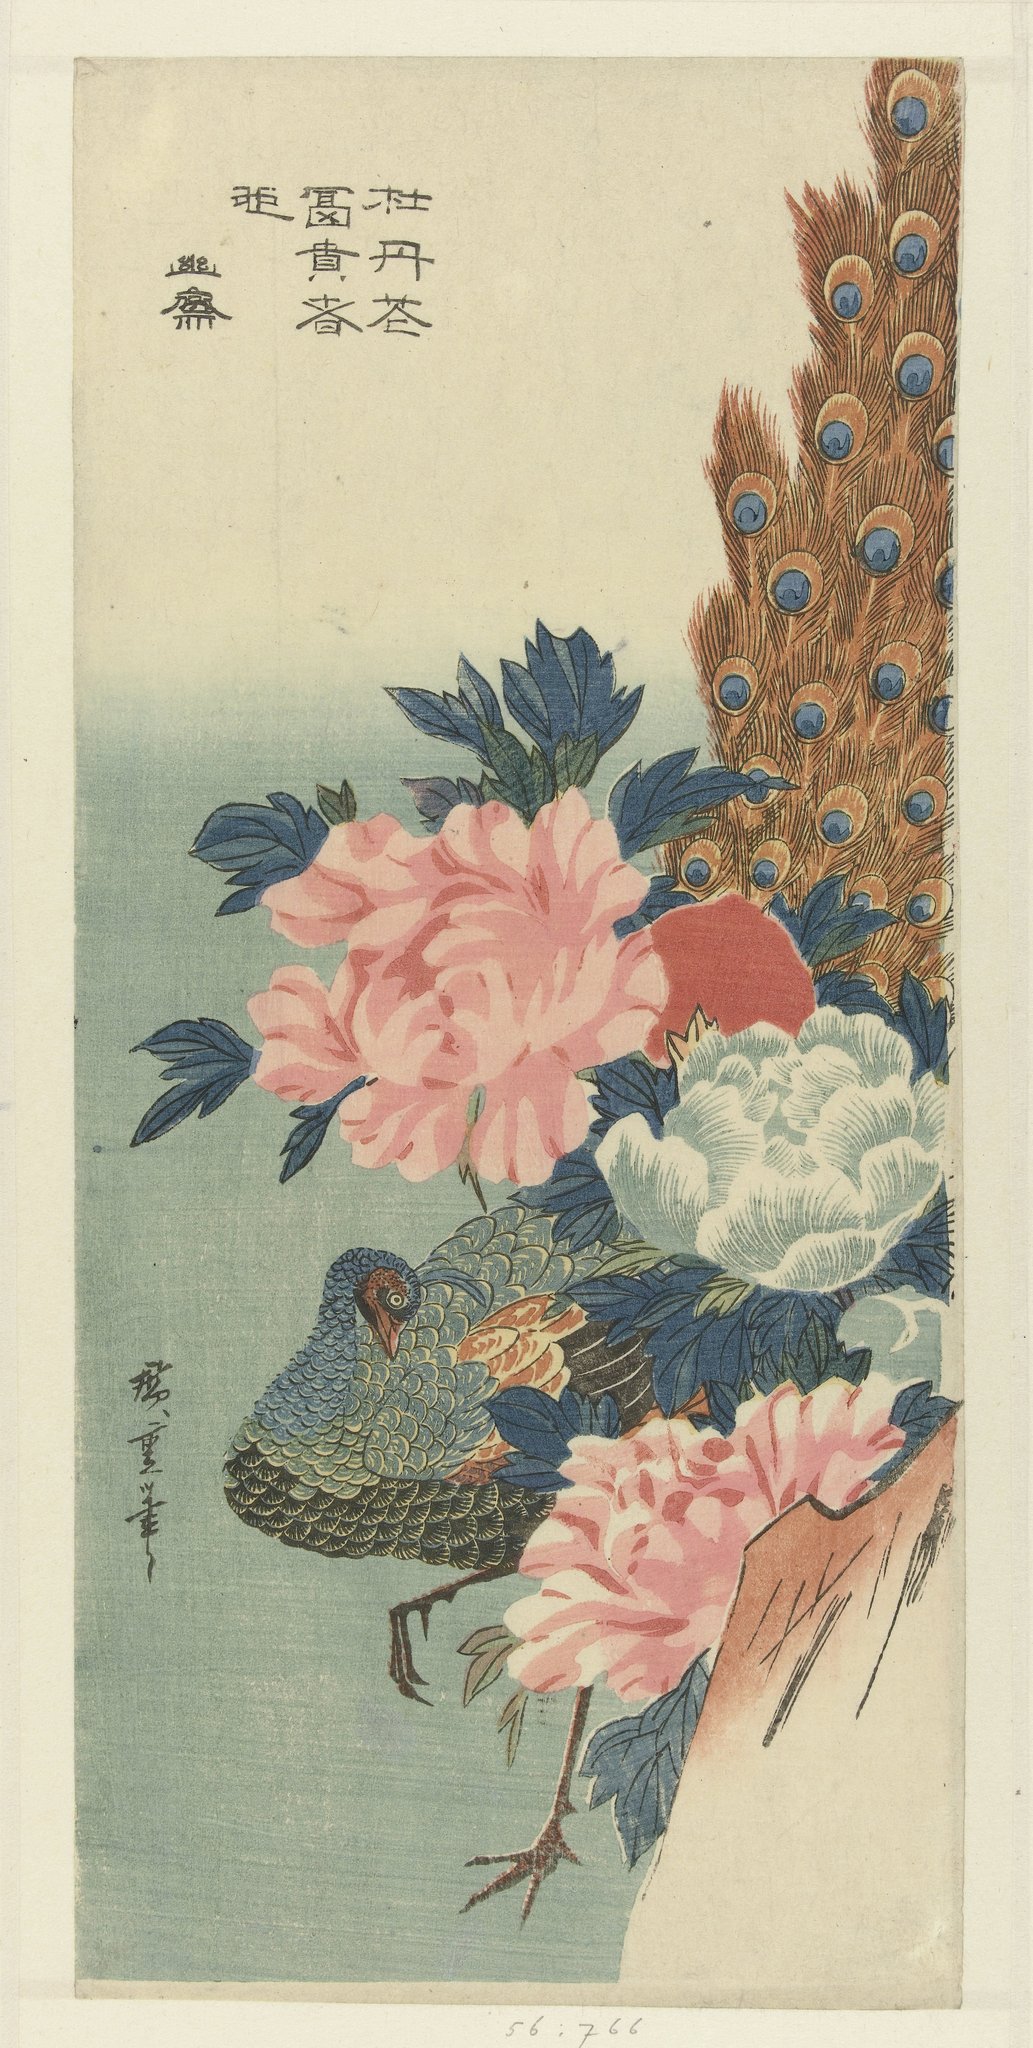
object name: print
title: Pauw en pioenrozen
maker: utagawa hiroshige (i)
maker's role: draughtsman, print maker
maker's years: 1797-1858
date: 1833-1837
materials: paper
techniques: woodcut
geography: japan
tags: plants and herbs: peony, ornamental birds: peacock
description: Pauw onder weelderig bloeiende pioenrozen; linksboven een gedicht.